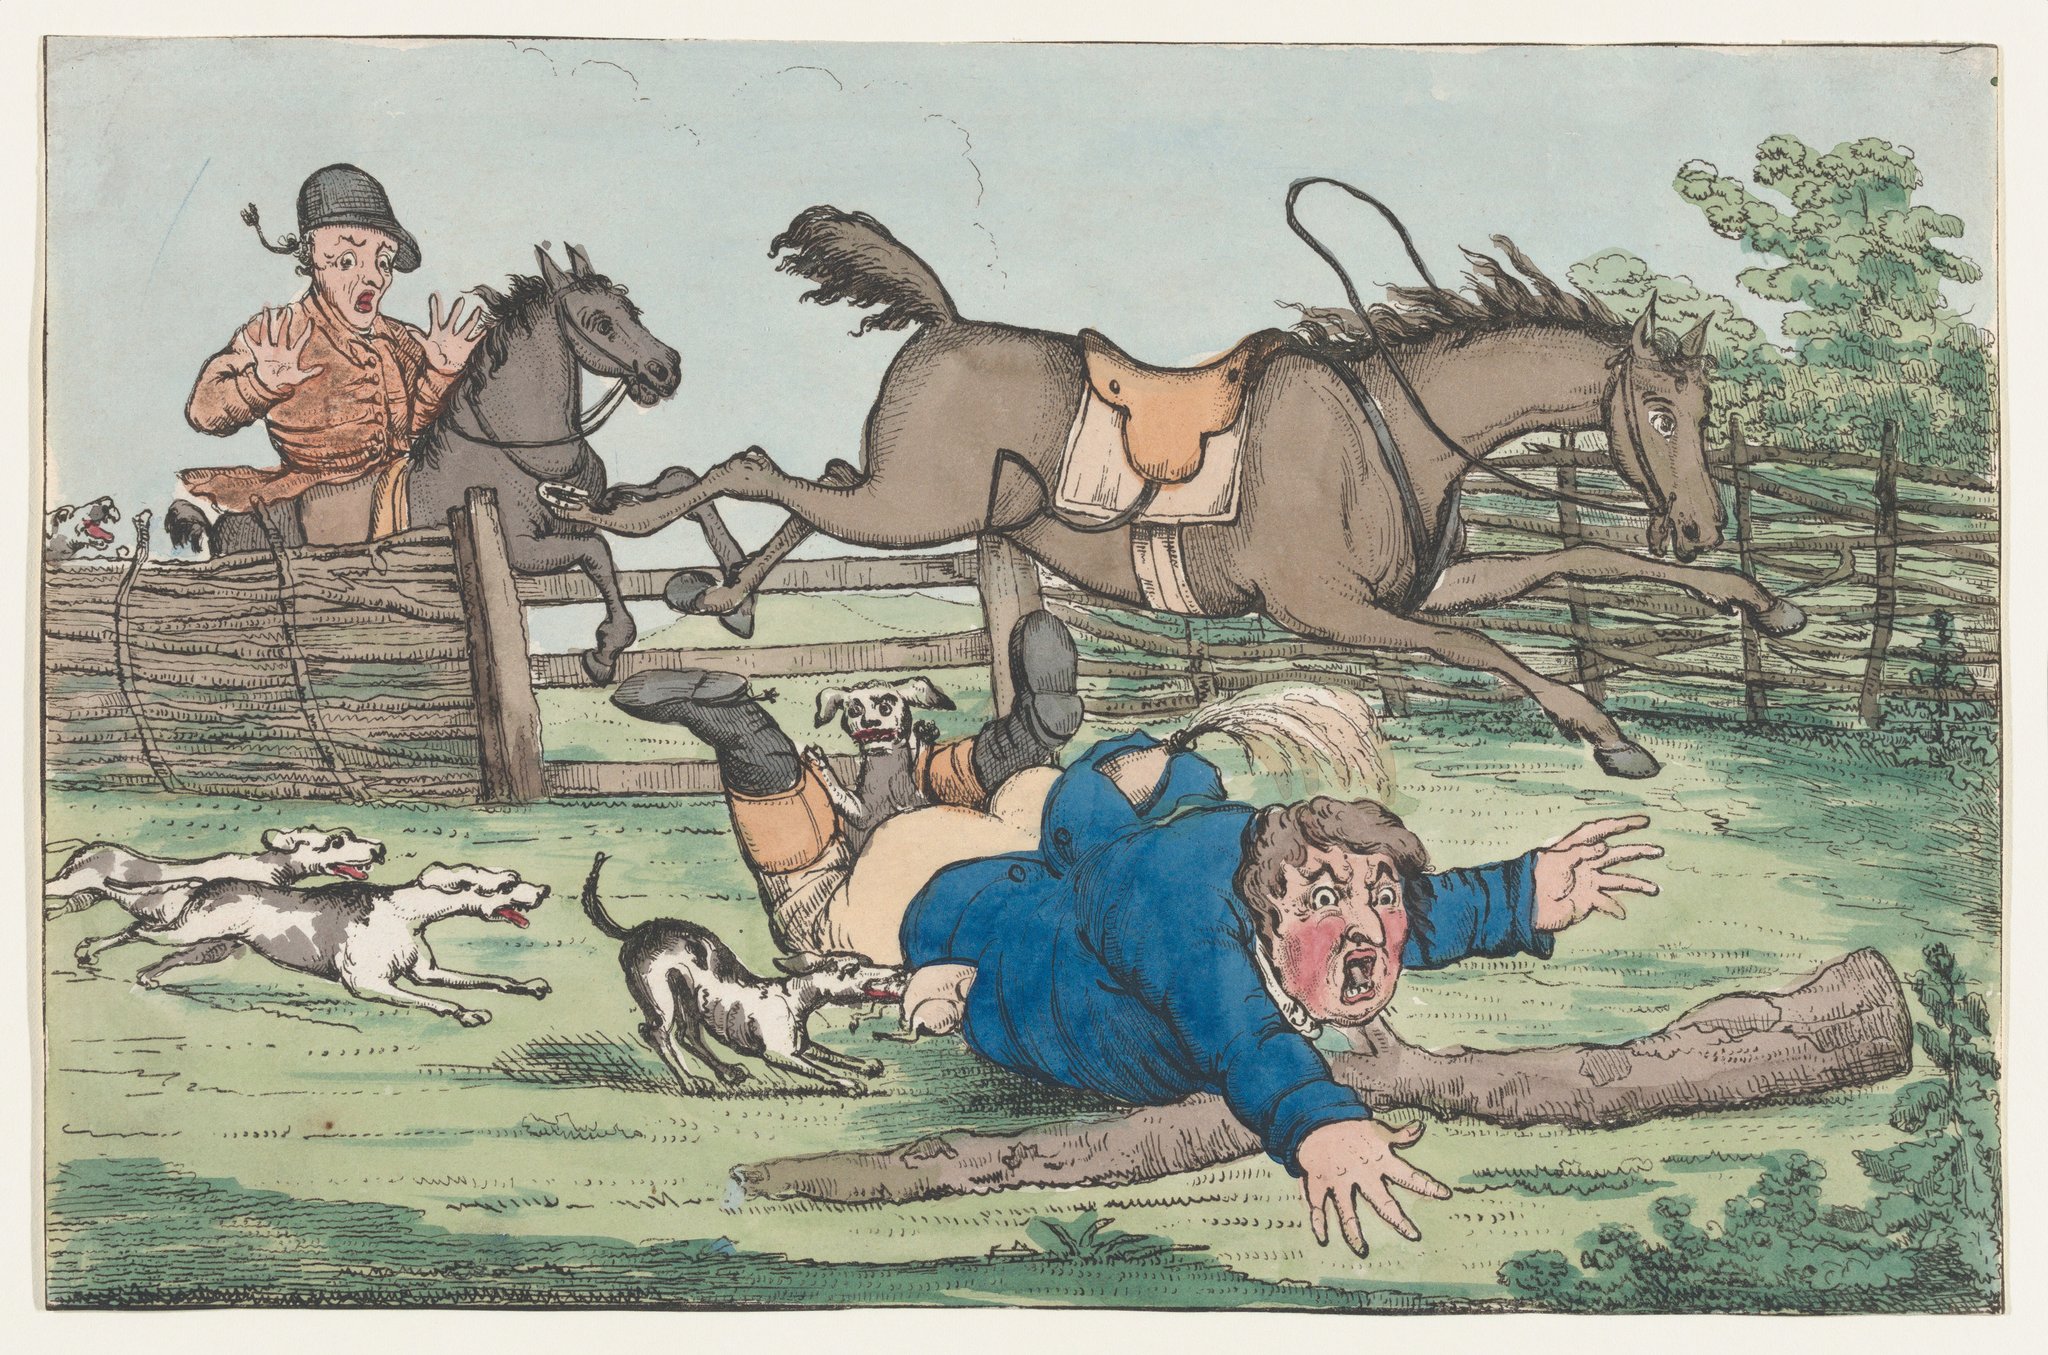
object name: print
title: Fallen Rider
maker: henry william bunbury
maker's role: artist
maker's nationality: british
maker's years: 1750-1811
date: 1780-1820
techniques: etching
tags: satire,men,dogs,horses